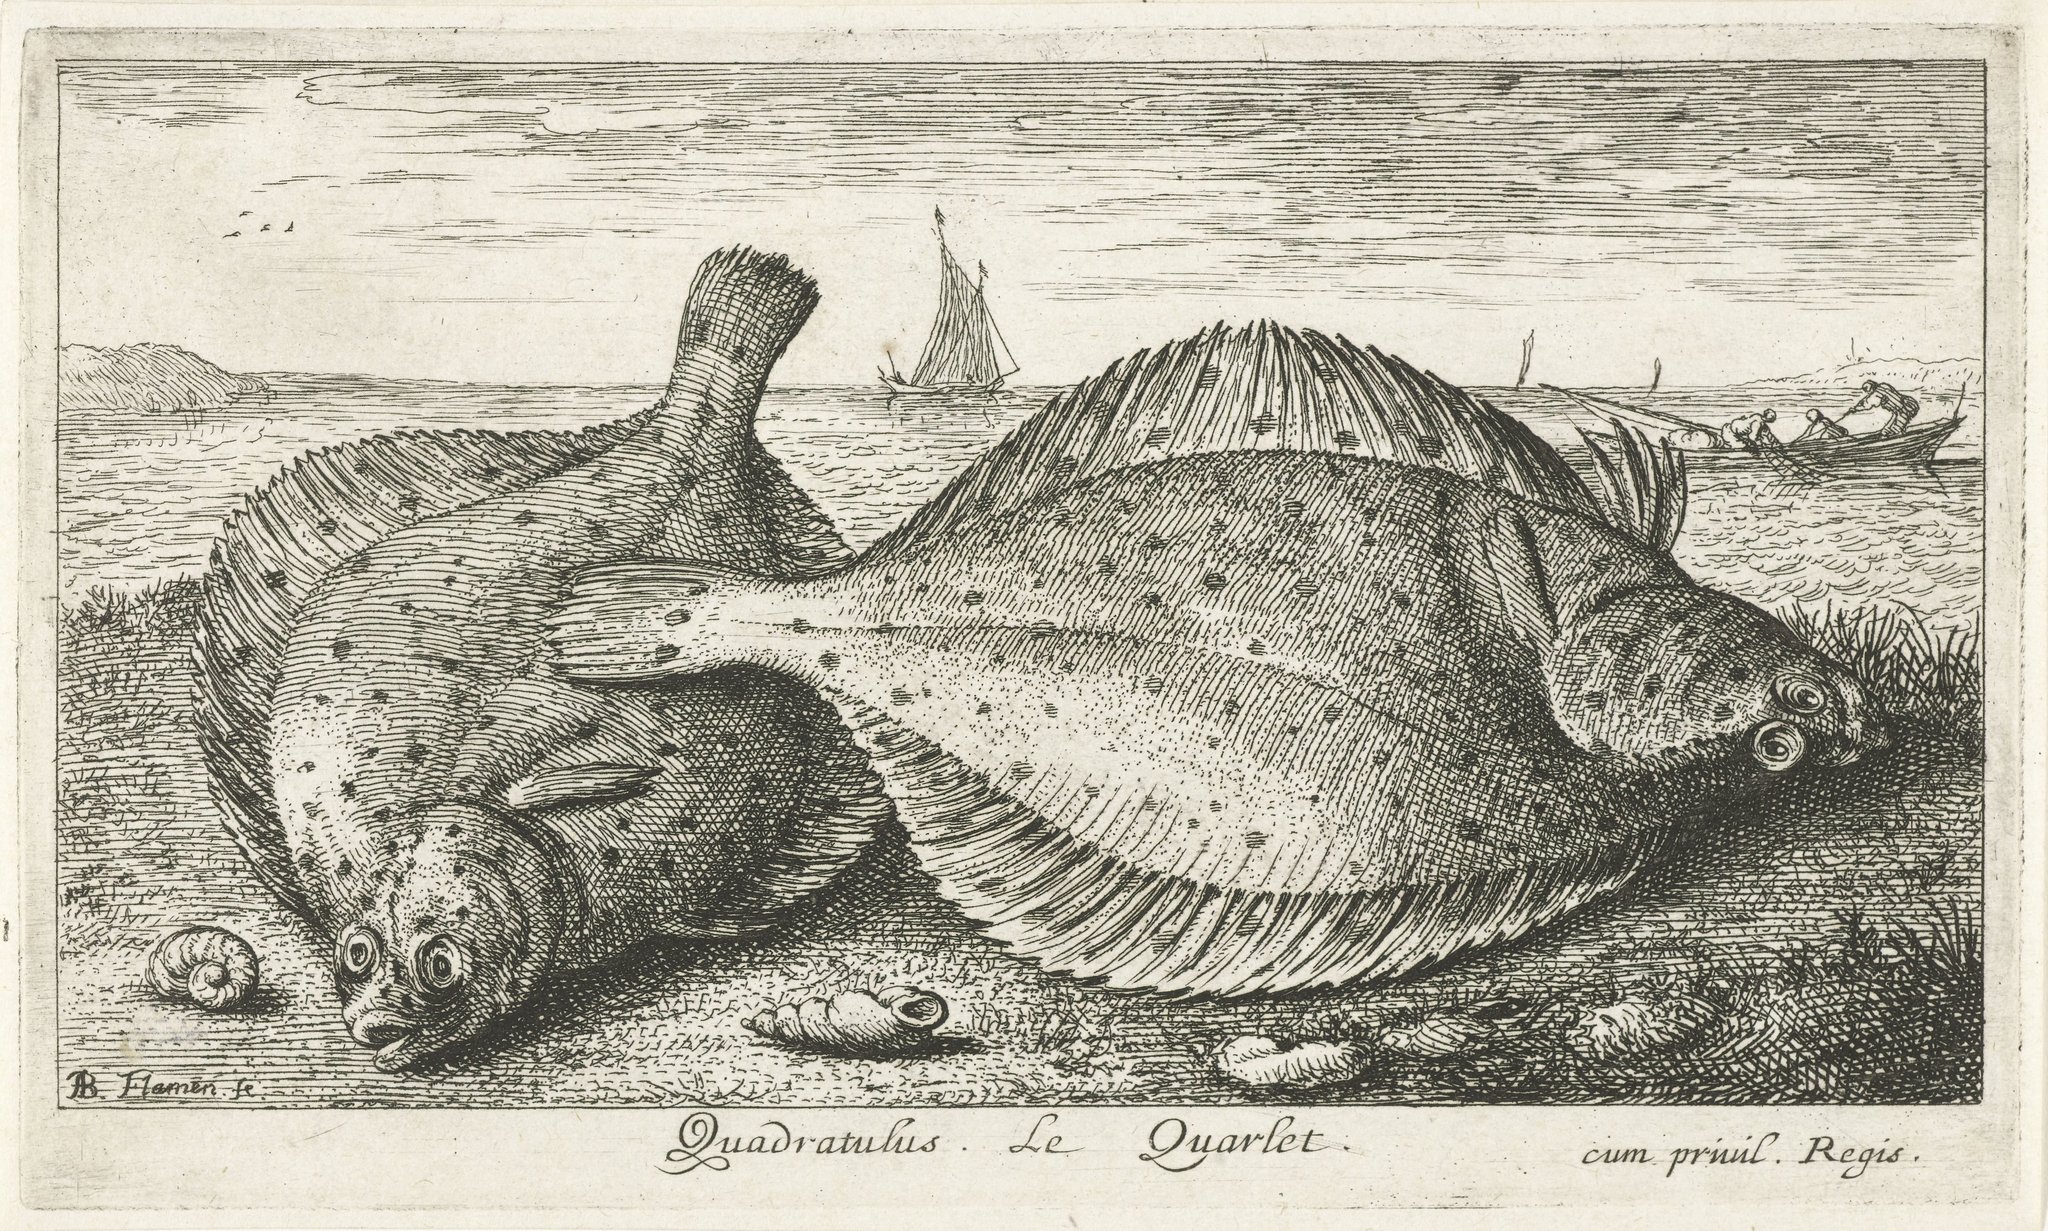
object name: print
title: Vissen en andere zeedieren - zoutwater derde reeks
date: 1664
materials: paper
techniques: etching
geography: paris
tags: fishes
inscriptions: collector's mark: Lugt 2228